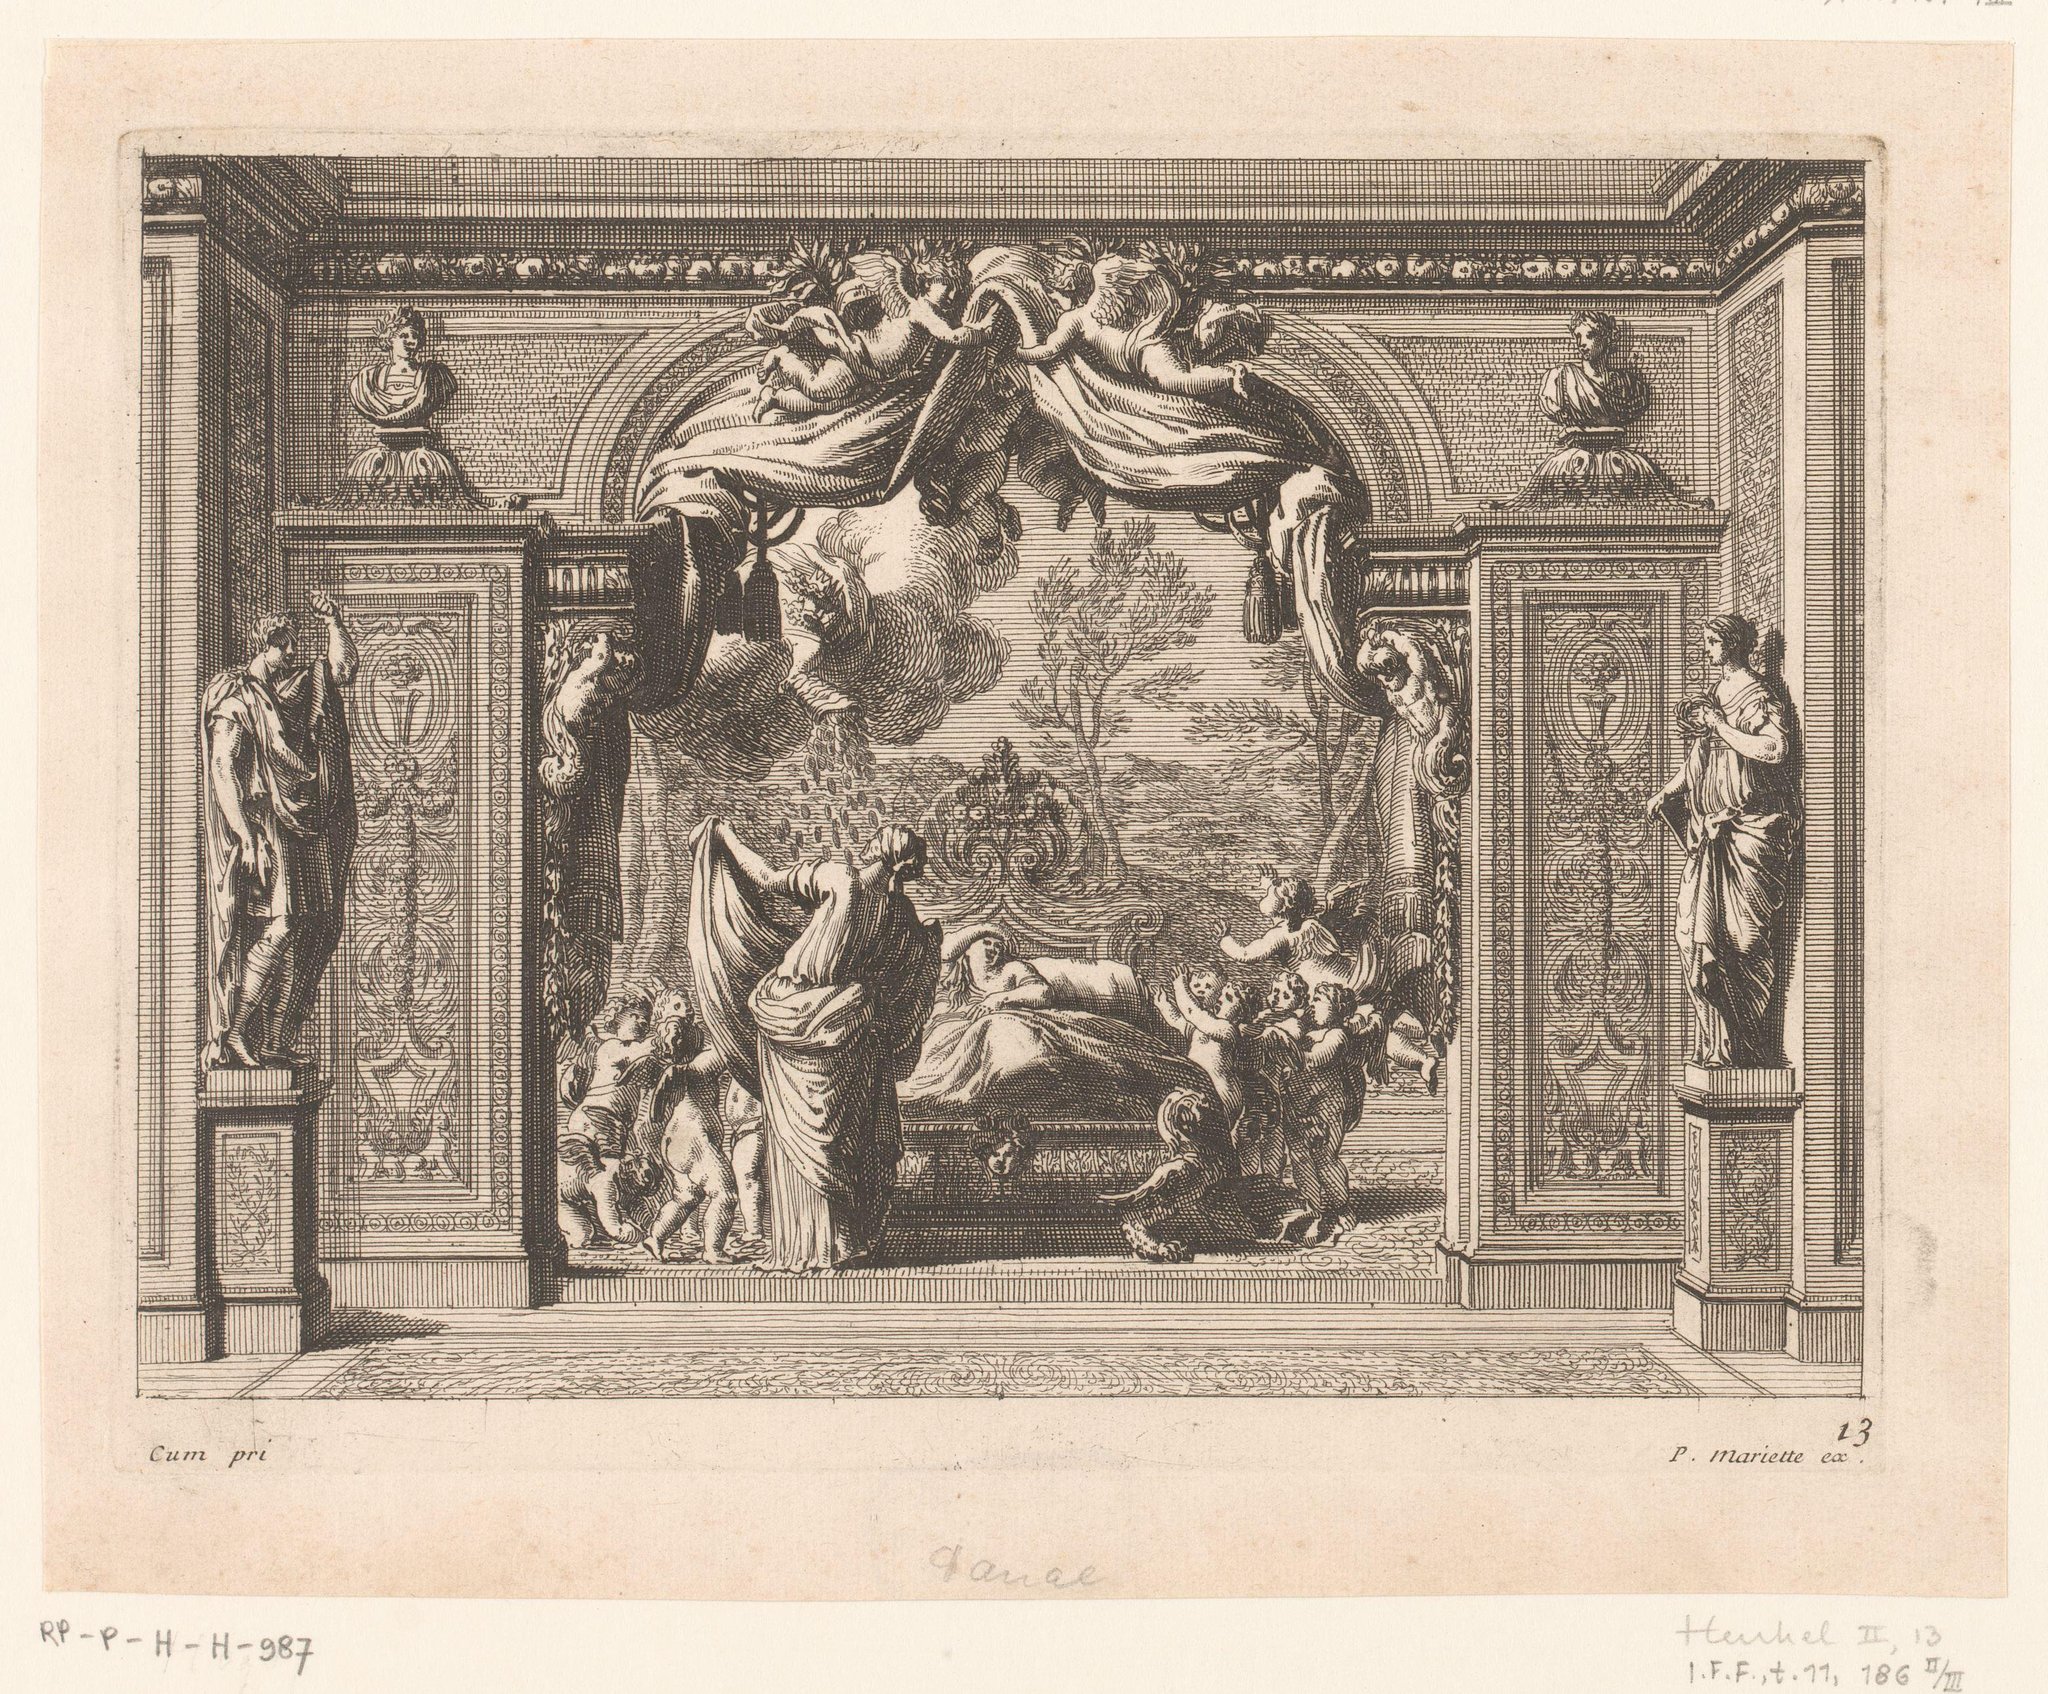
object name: print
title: Mythologische scènes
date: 1628-1682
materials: paper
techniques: etching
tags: jupiter wooing danae; she is usually lying in bed receiving a shower of gold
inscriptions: collector's mark: Lugt 11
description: Maakt deel uit van een twintigdelige serie met mythologische scènes.